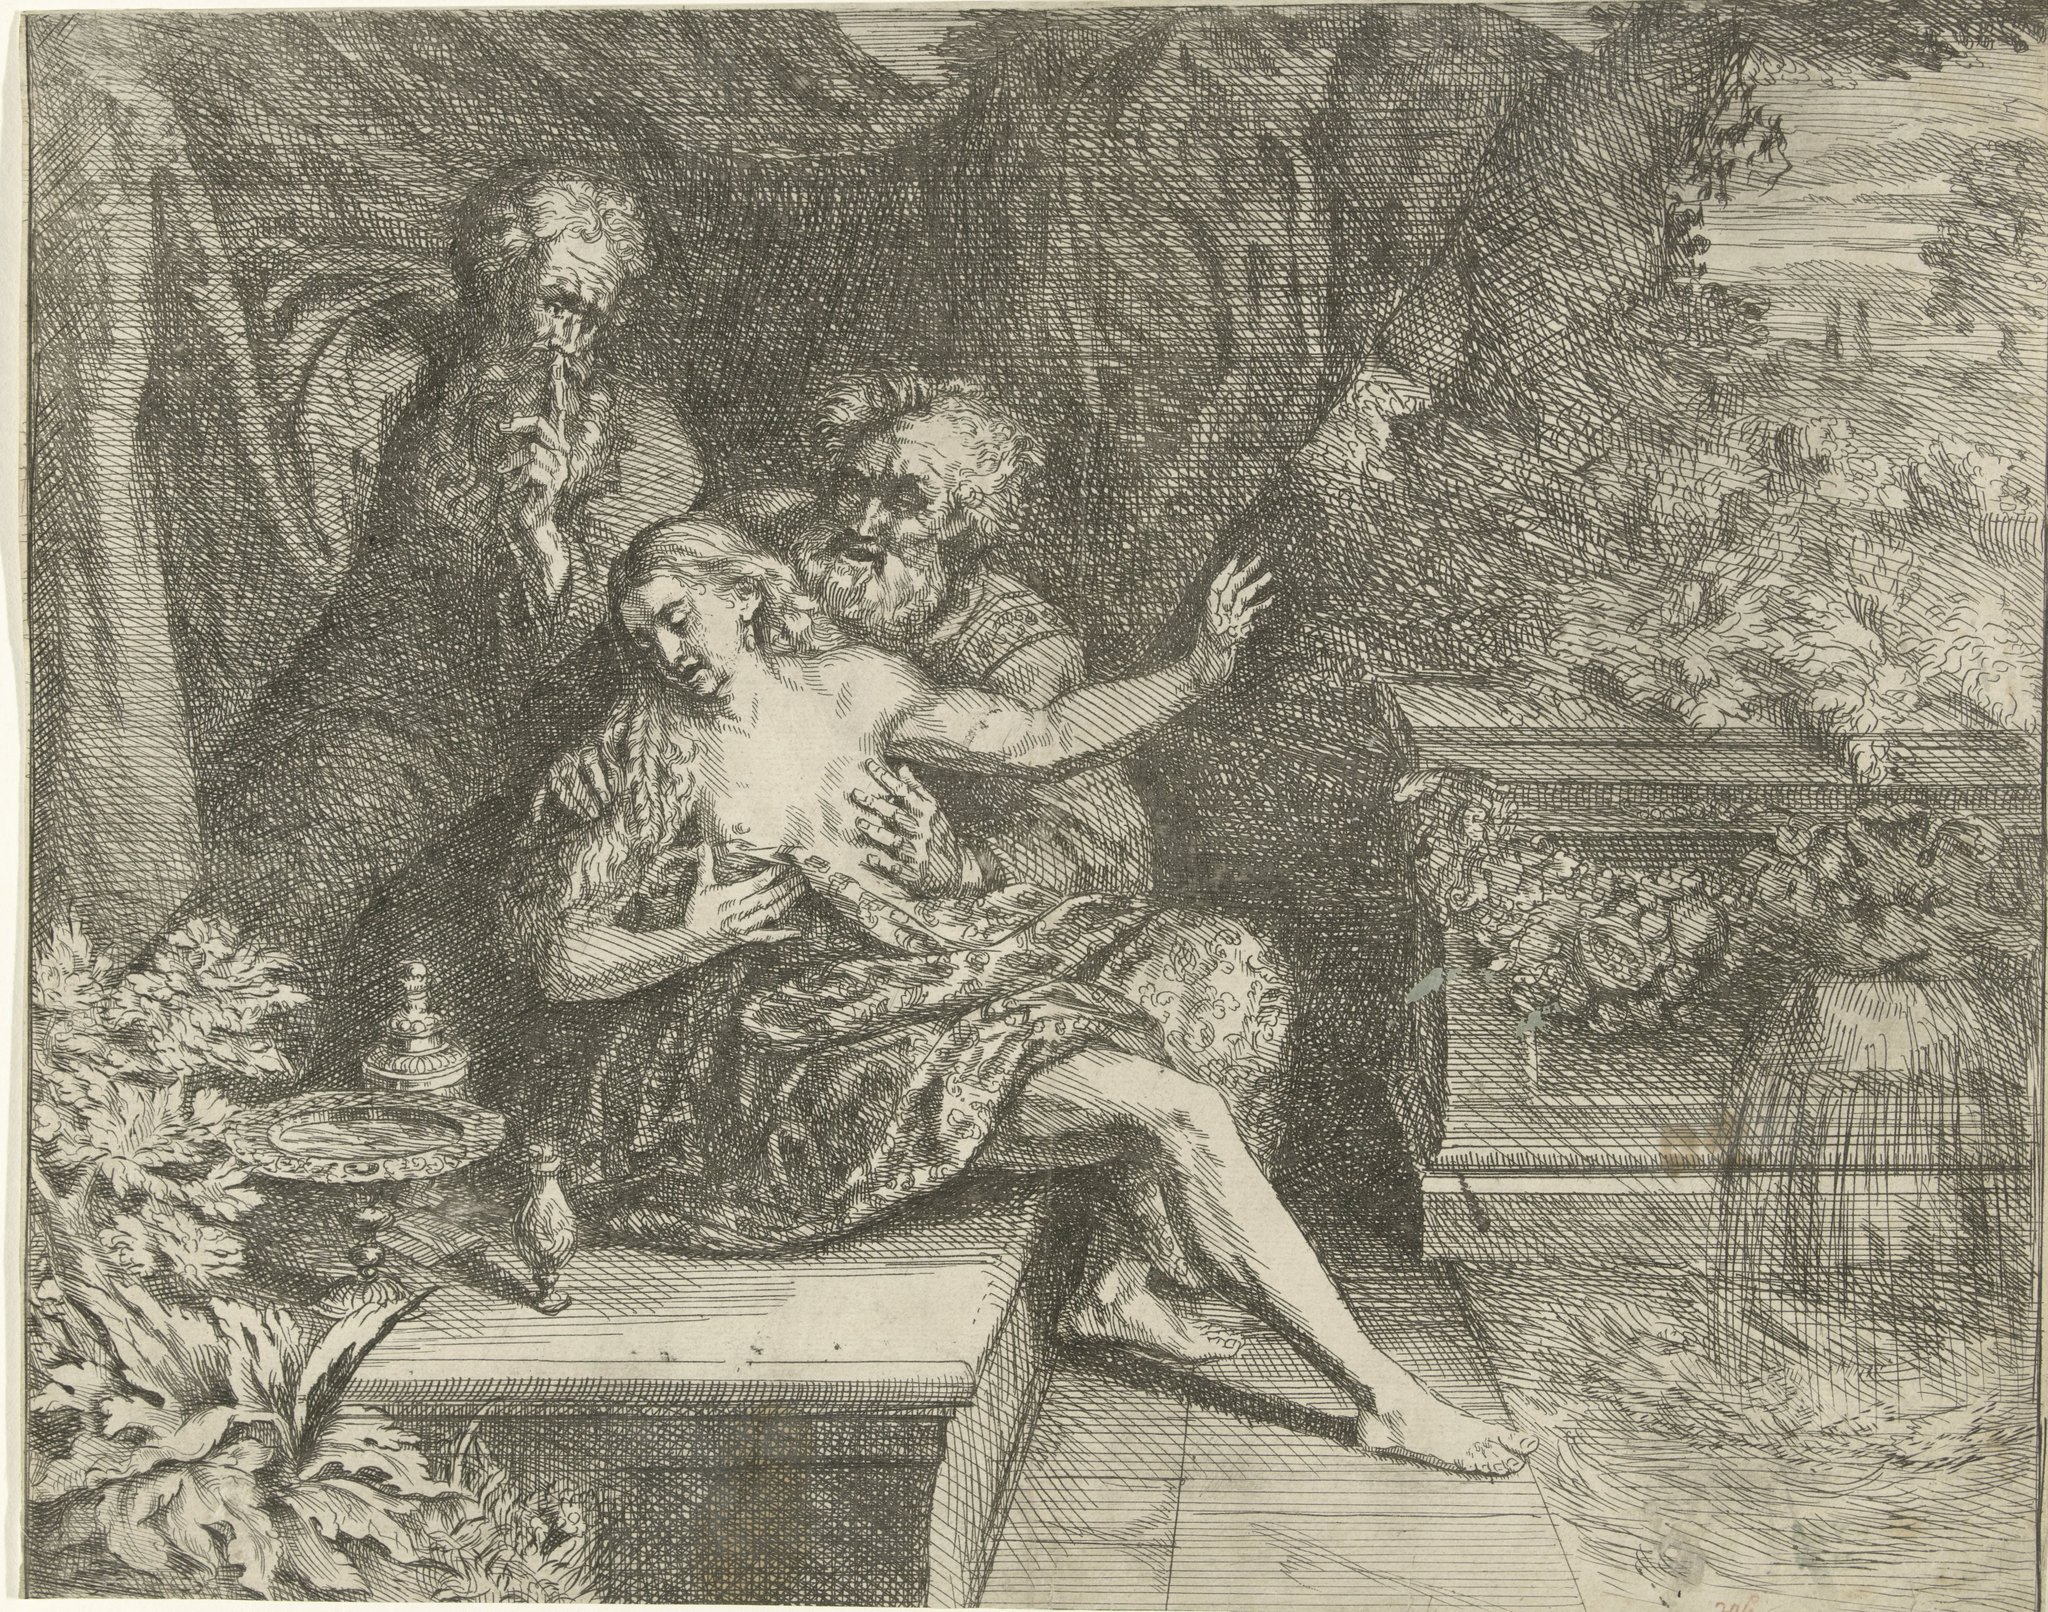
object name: print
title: Suzanna en de ouderlingen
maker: willem de ryck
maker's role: print maker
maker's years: 1635-1699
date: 1645-1699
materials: paper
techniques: etching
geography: europe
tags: the elders making advances towards susanna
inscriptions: collector's mark: Lugt 2165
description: Suzanna wordt tijdens haar bad overvallen door twee ouderlingen. Zij zit op de rand van een bassin terwijl een van de mannen haar betast. De andere man maakt een gebaar om haar tot zwijgen te brengen.